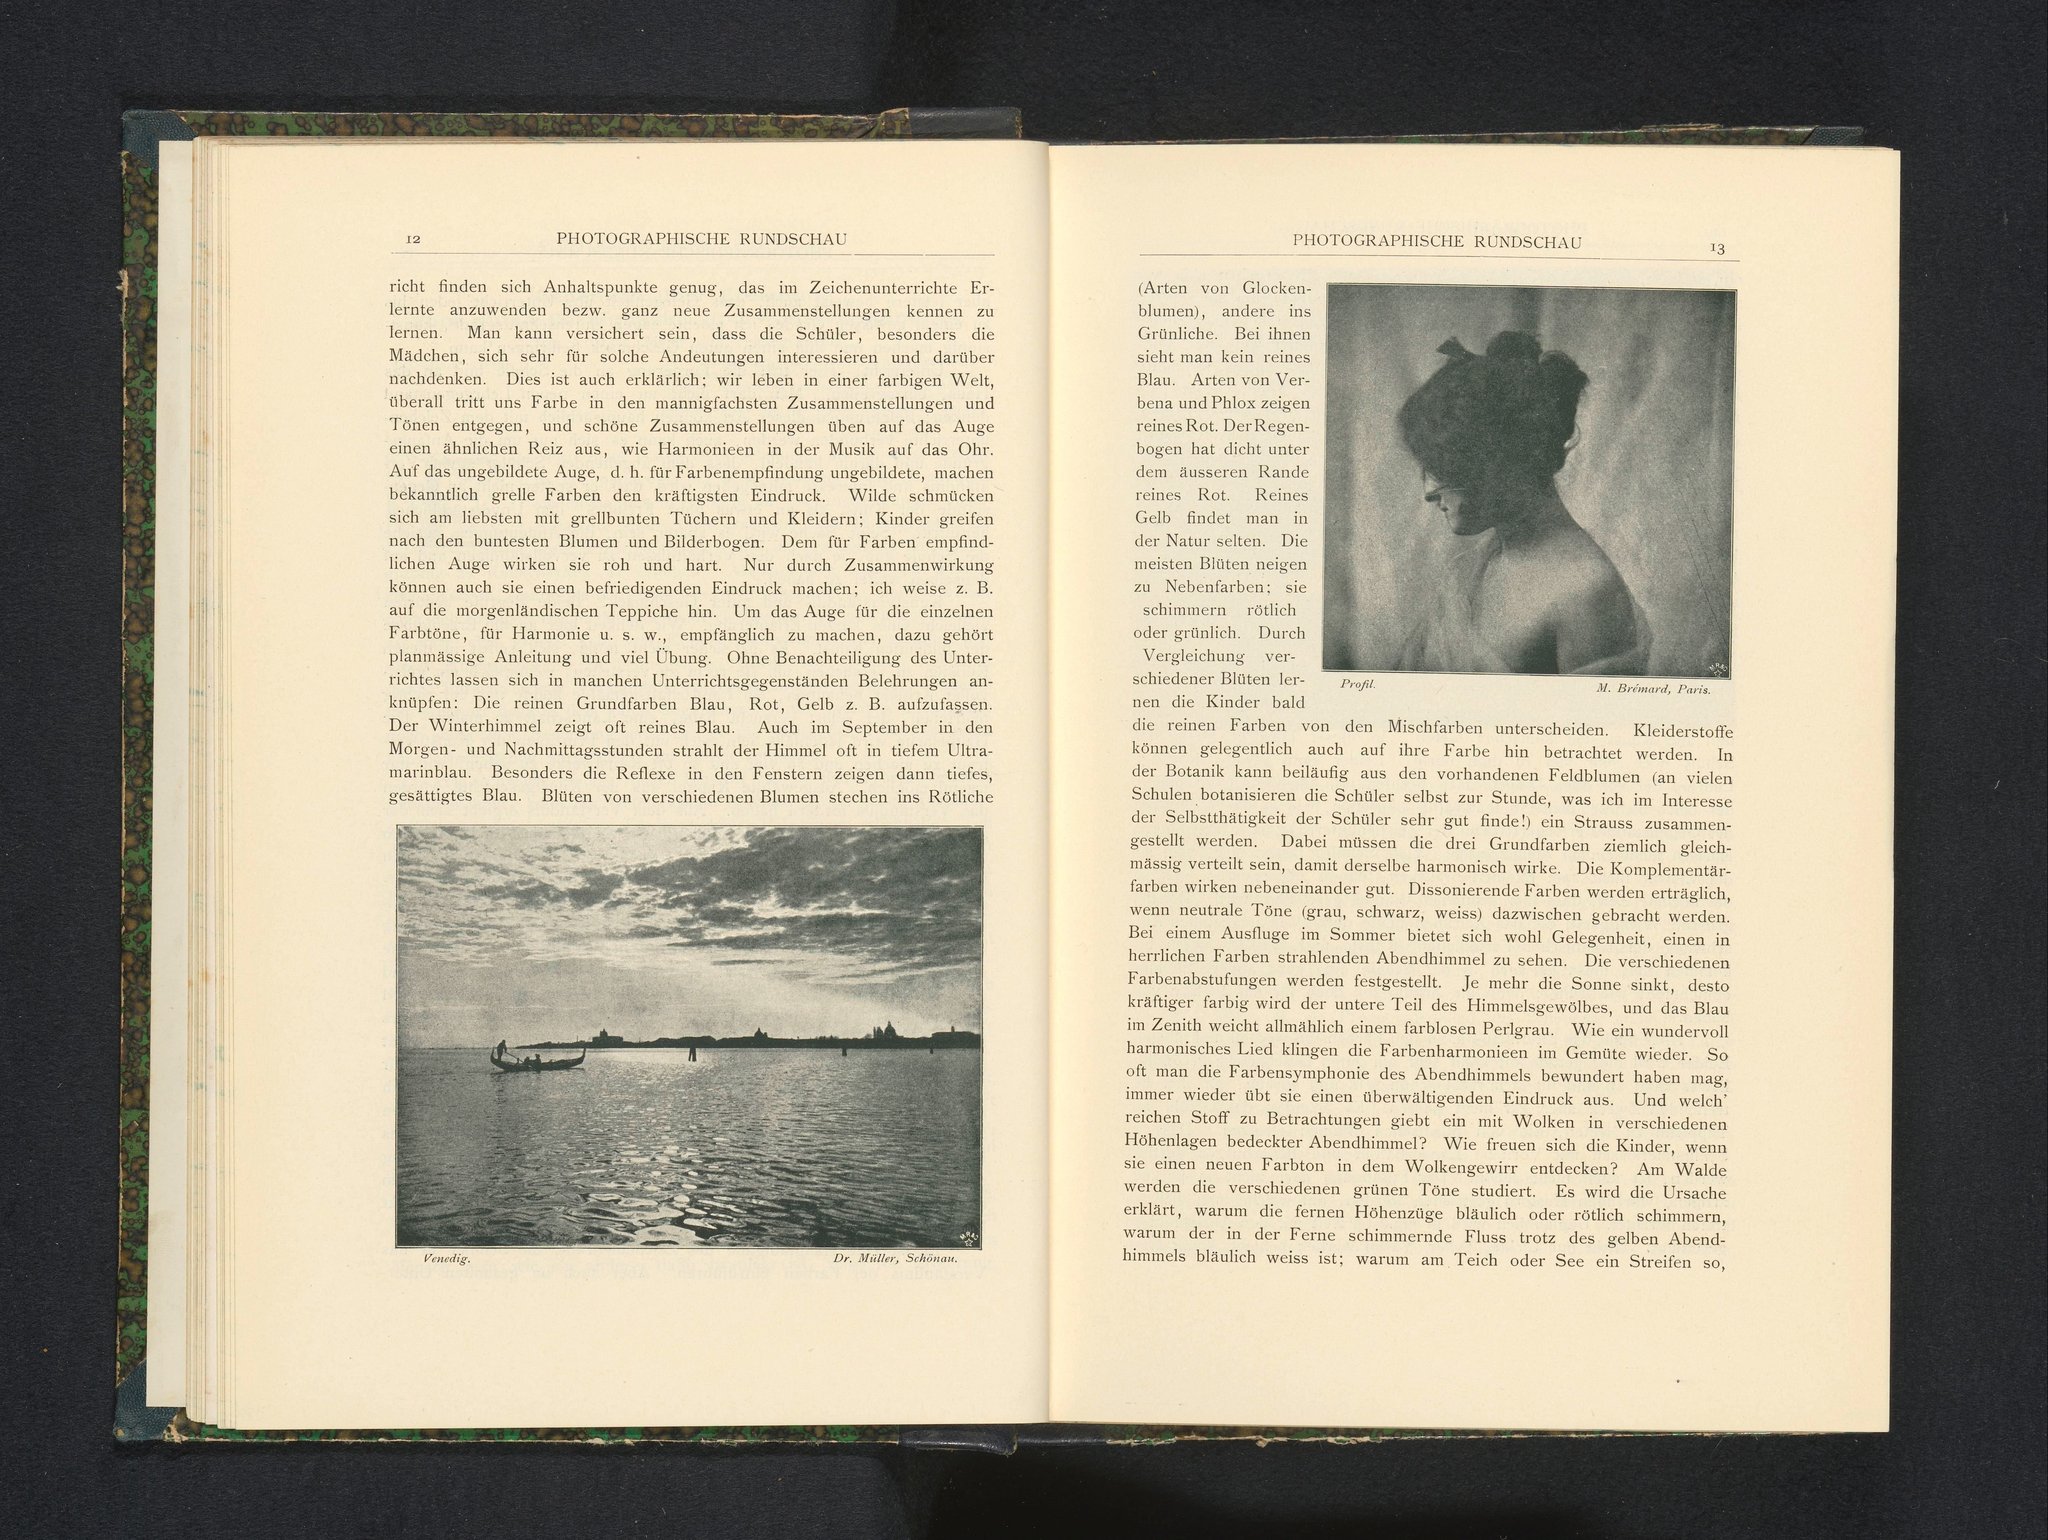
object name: page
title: Gezicht op een gondel met de stad Venetië op de achtergrond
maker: otto h. müller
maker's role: fotograaf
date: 1894-1899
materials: paper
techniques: autotype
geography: venice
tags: canals, waters (in city), venice